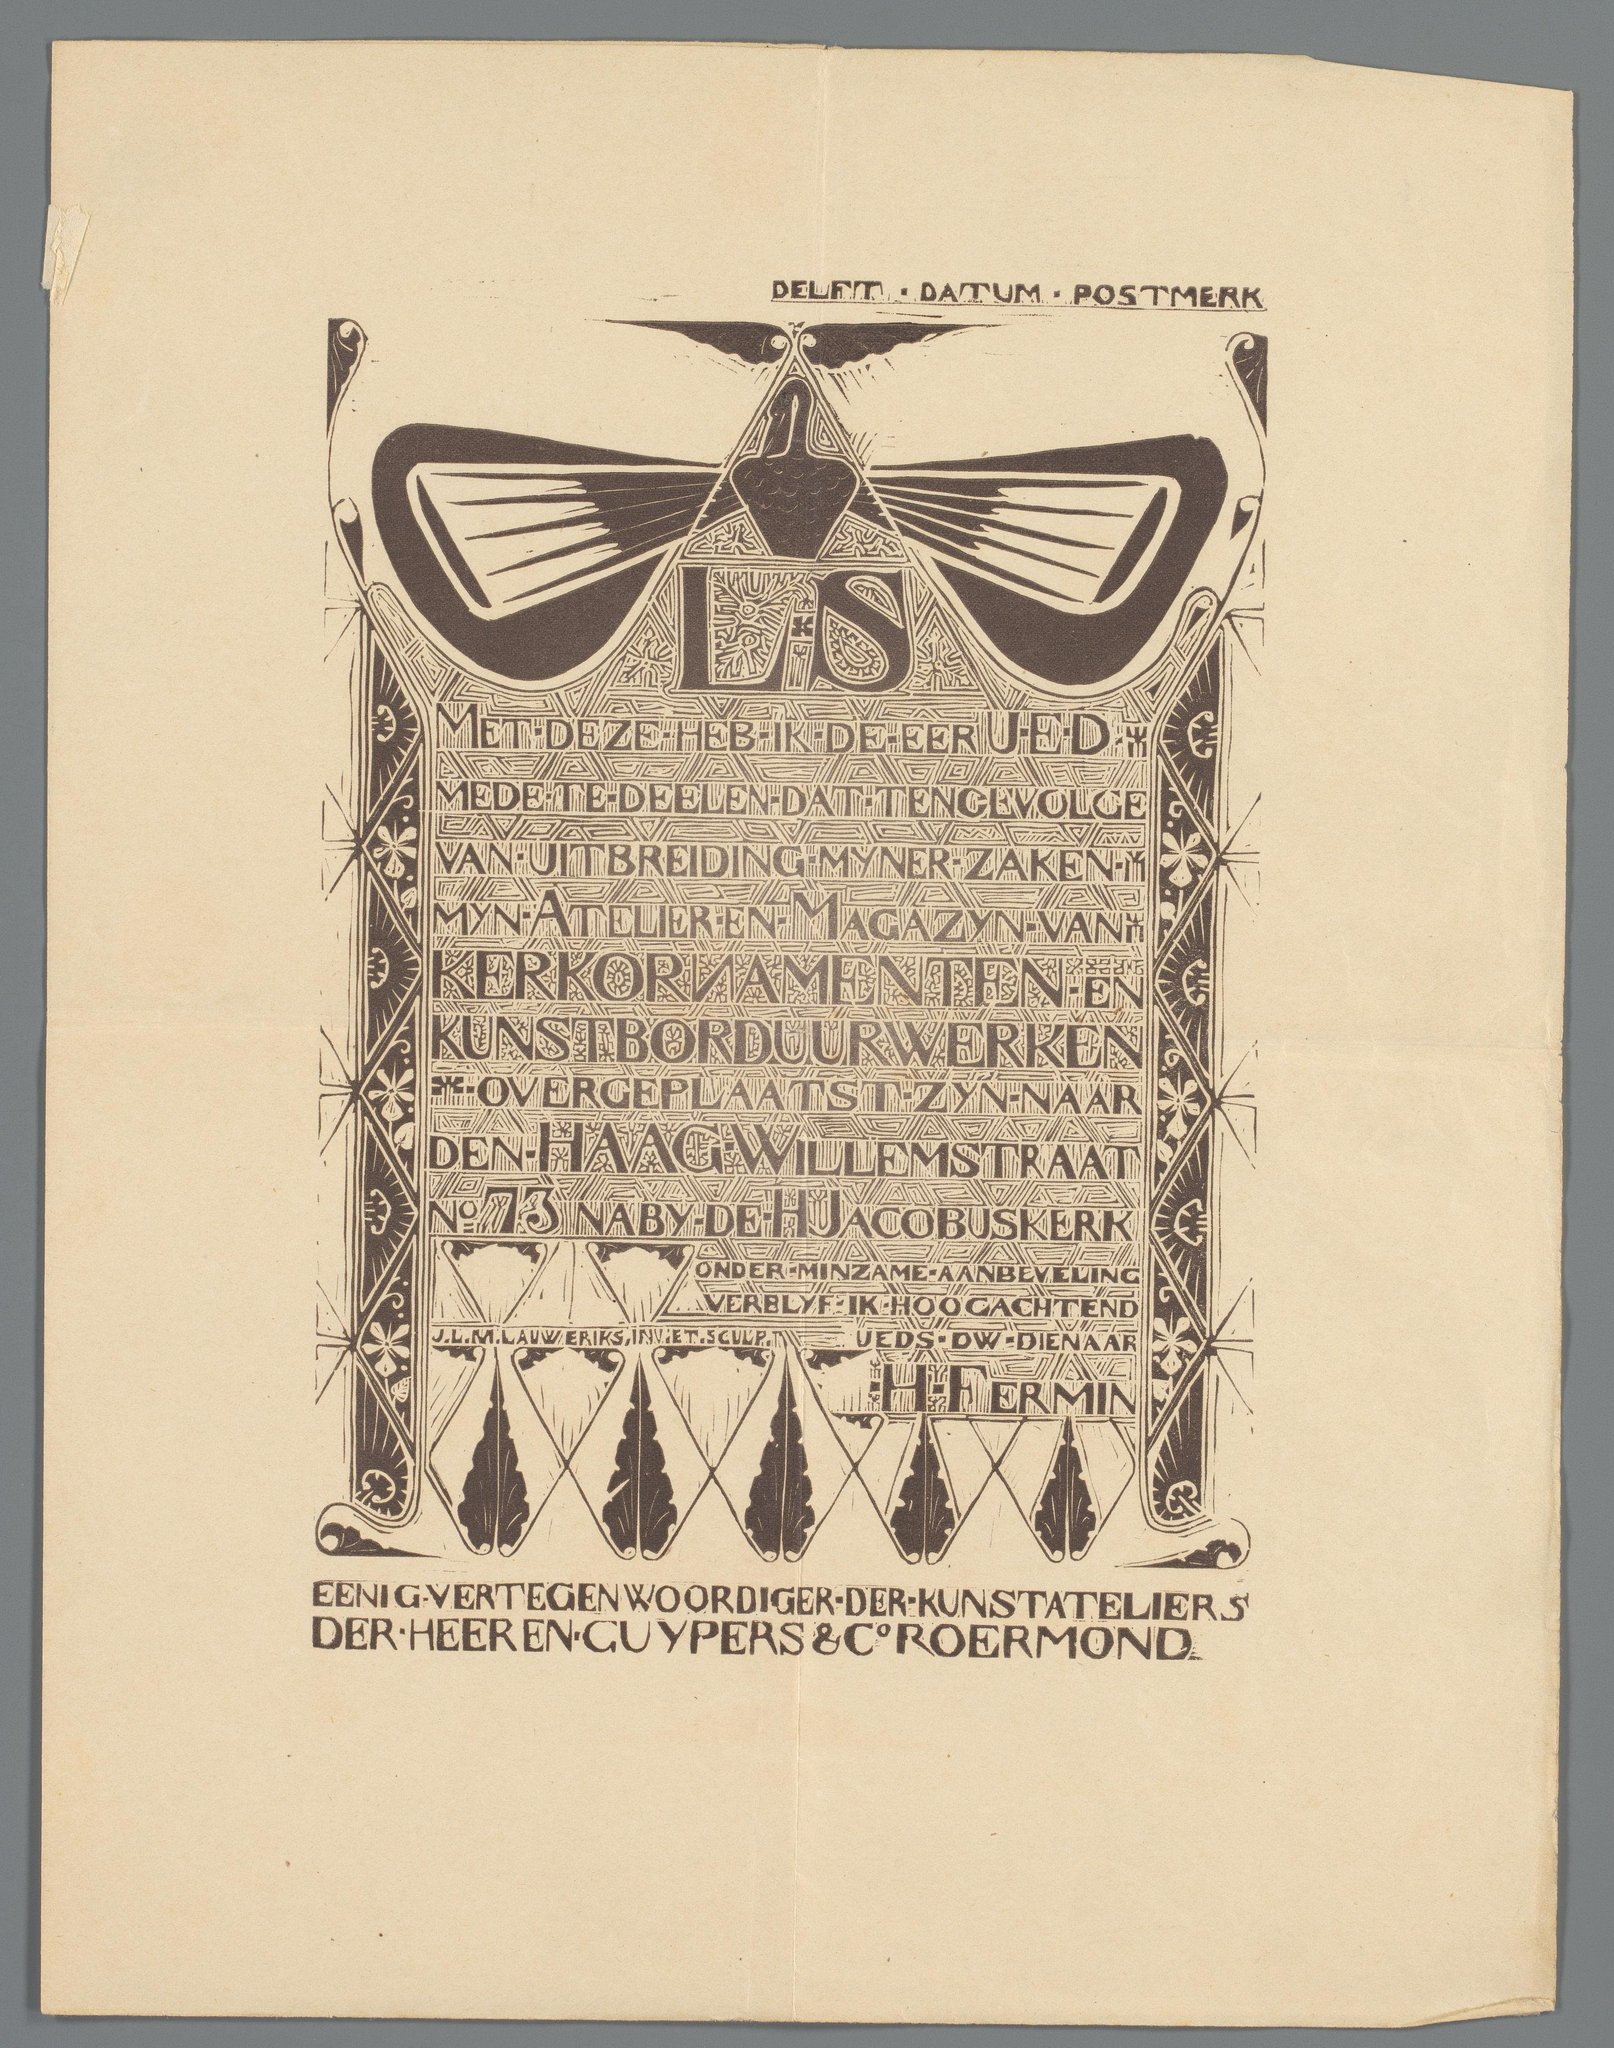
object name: moving announcement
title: Verhuisaankondiging van het atelier en magazijn van Hubert Fermin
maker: mathieu lauweriks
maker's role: designer, draughtsman, print maker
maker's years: 1864-1932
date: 1894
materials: paper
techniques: woodcut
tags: maastricht, moving (house), water-birds: pelican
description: Een decoratieve rand met bovenaan een pelikaan en uitgespreide vleugels. In de tekst wordt kenbaar gemaakt dat vanwege uitbreiding het atelier en magazijn van kerkornamenten en kunstborduurwerken verhuist van Delft naar Den Haag.